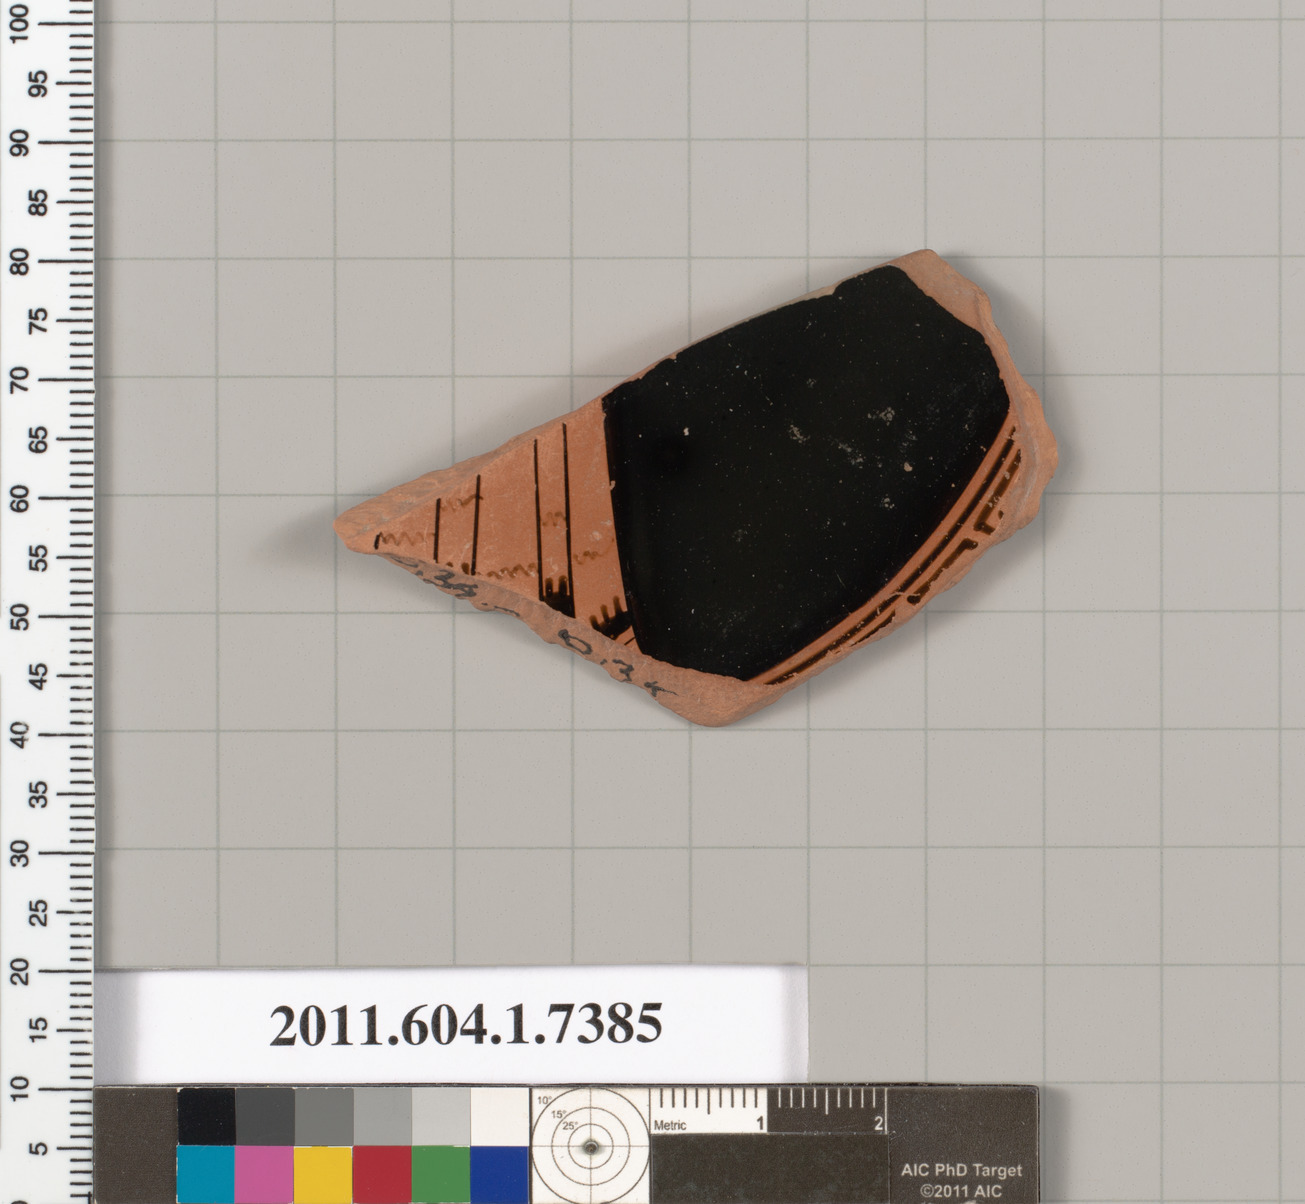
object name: kylix fragment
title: Terracotta fragment of a kylix (drinking cup)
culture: greek, attic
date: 500-480 BCE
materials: terracotta